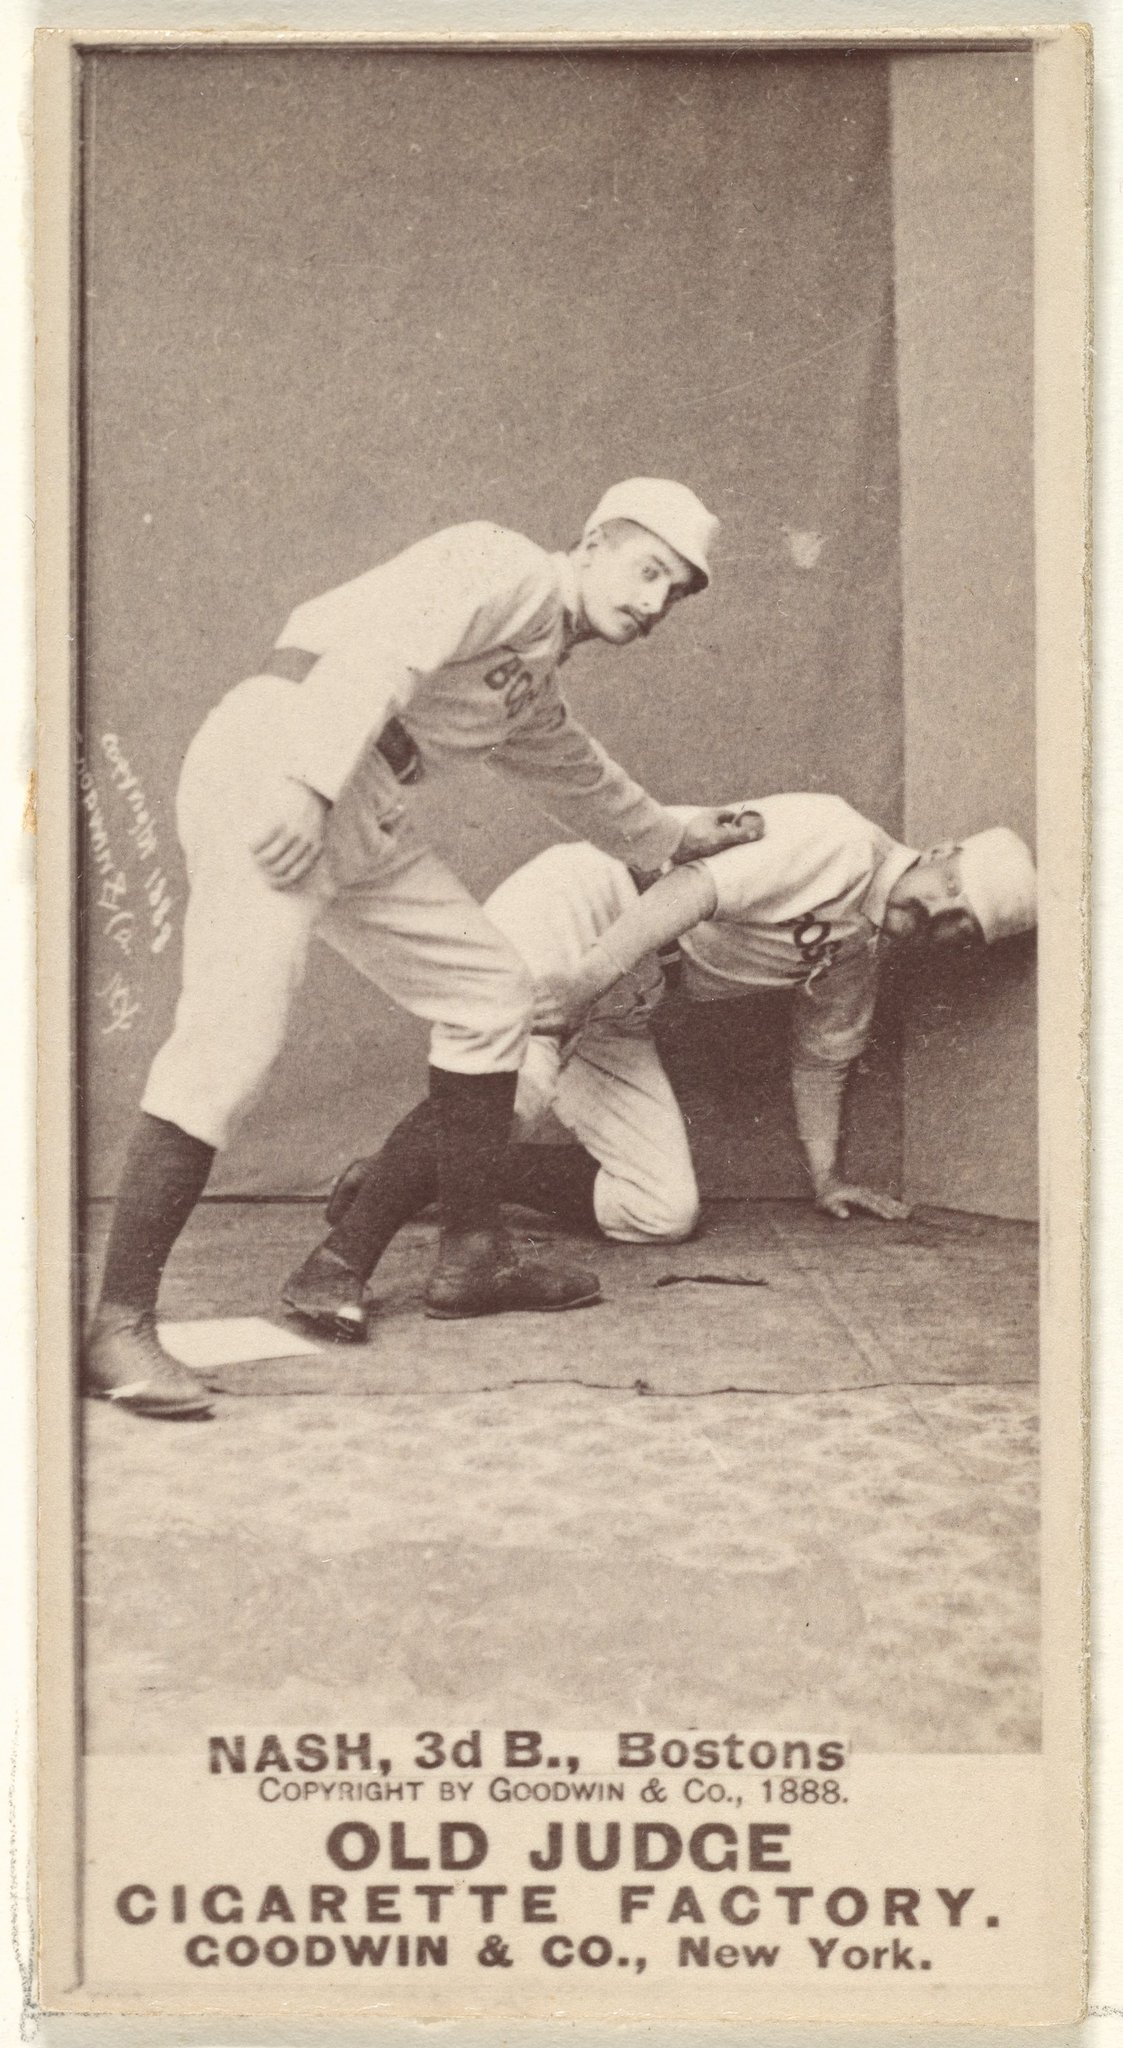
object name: baseball card, photograph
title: Nash, 3rd Base, Boston, from the Old Judge series (N172) for Old Judge Cigarettes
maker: goodwin & company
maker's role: publisher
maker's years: 1850-1950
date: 1888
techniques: albumen silver print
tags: men,portraits,baseball,athletes